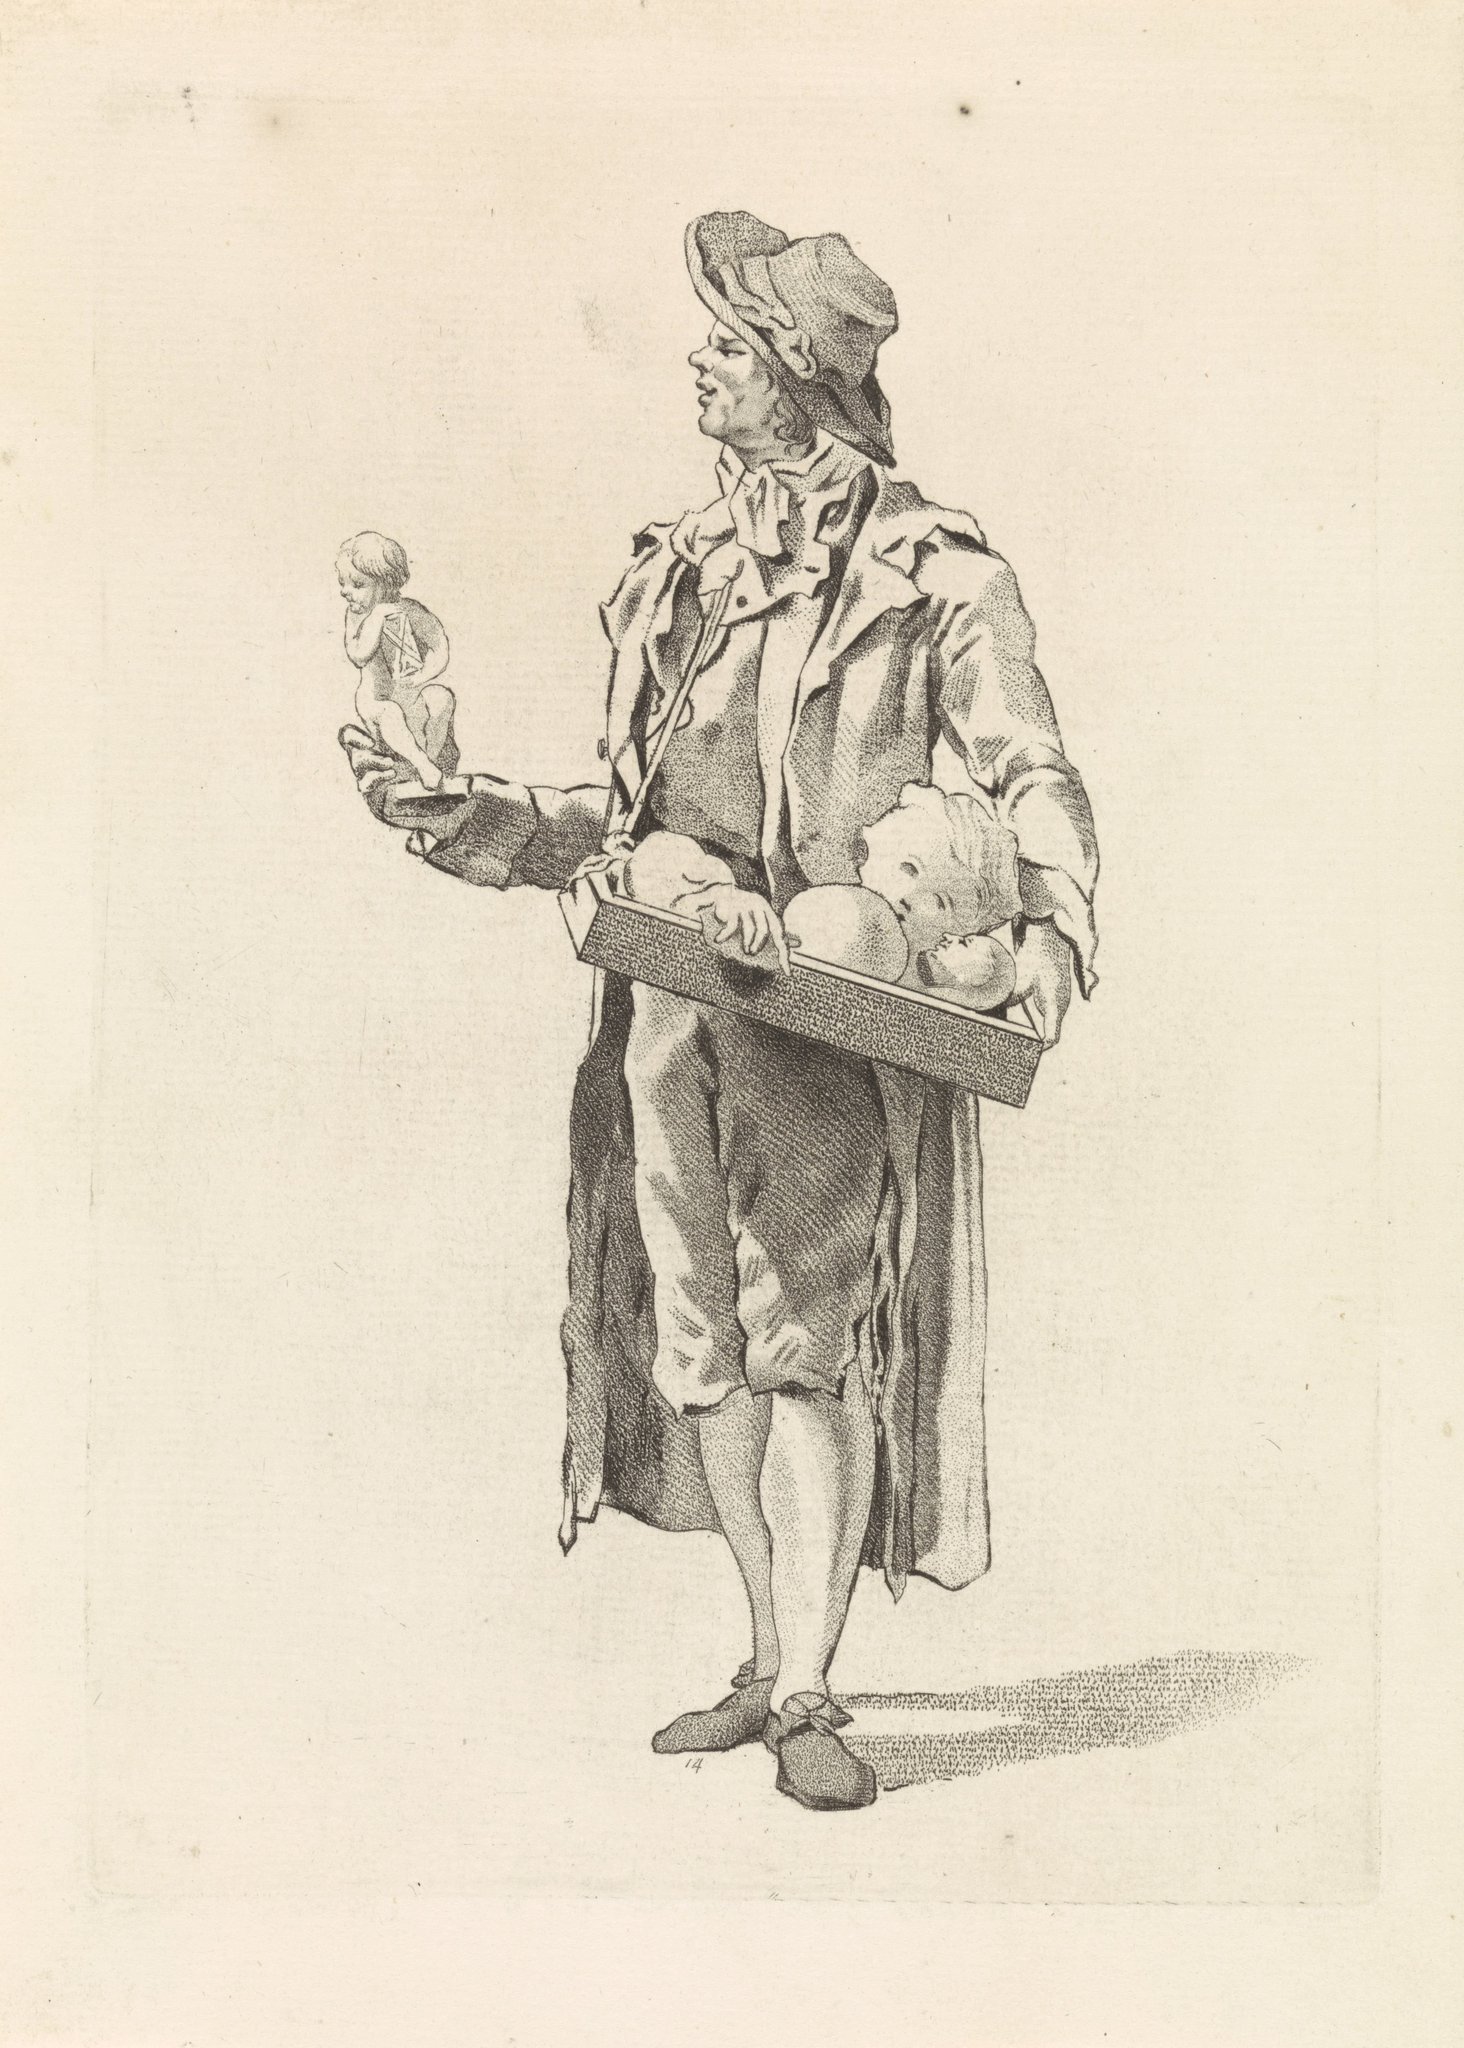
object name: print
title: Straatventer met gipsbeeldjes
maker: mathias de sallieth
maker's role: print maker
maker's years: 1749-1791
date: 1772-1791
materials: paper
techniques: printmaking, etching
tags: street-trader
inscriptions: collector's mark: Lugt 2228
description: De prent verscheen vanaf 1818 tevens als onderdeel van een 33-delige reeks prenten door Mathias de Sallieth, samengebonden in: Perkois, Jacobus, Prins, Johannes Huibert. Verzameling van verschillende gekleede mans- en vrouwenstanden, ter oefening van jonge schilders en liefhebbers. Rotterdam: Johannes Immerzeel, 1818.